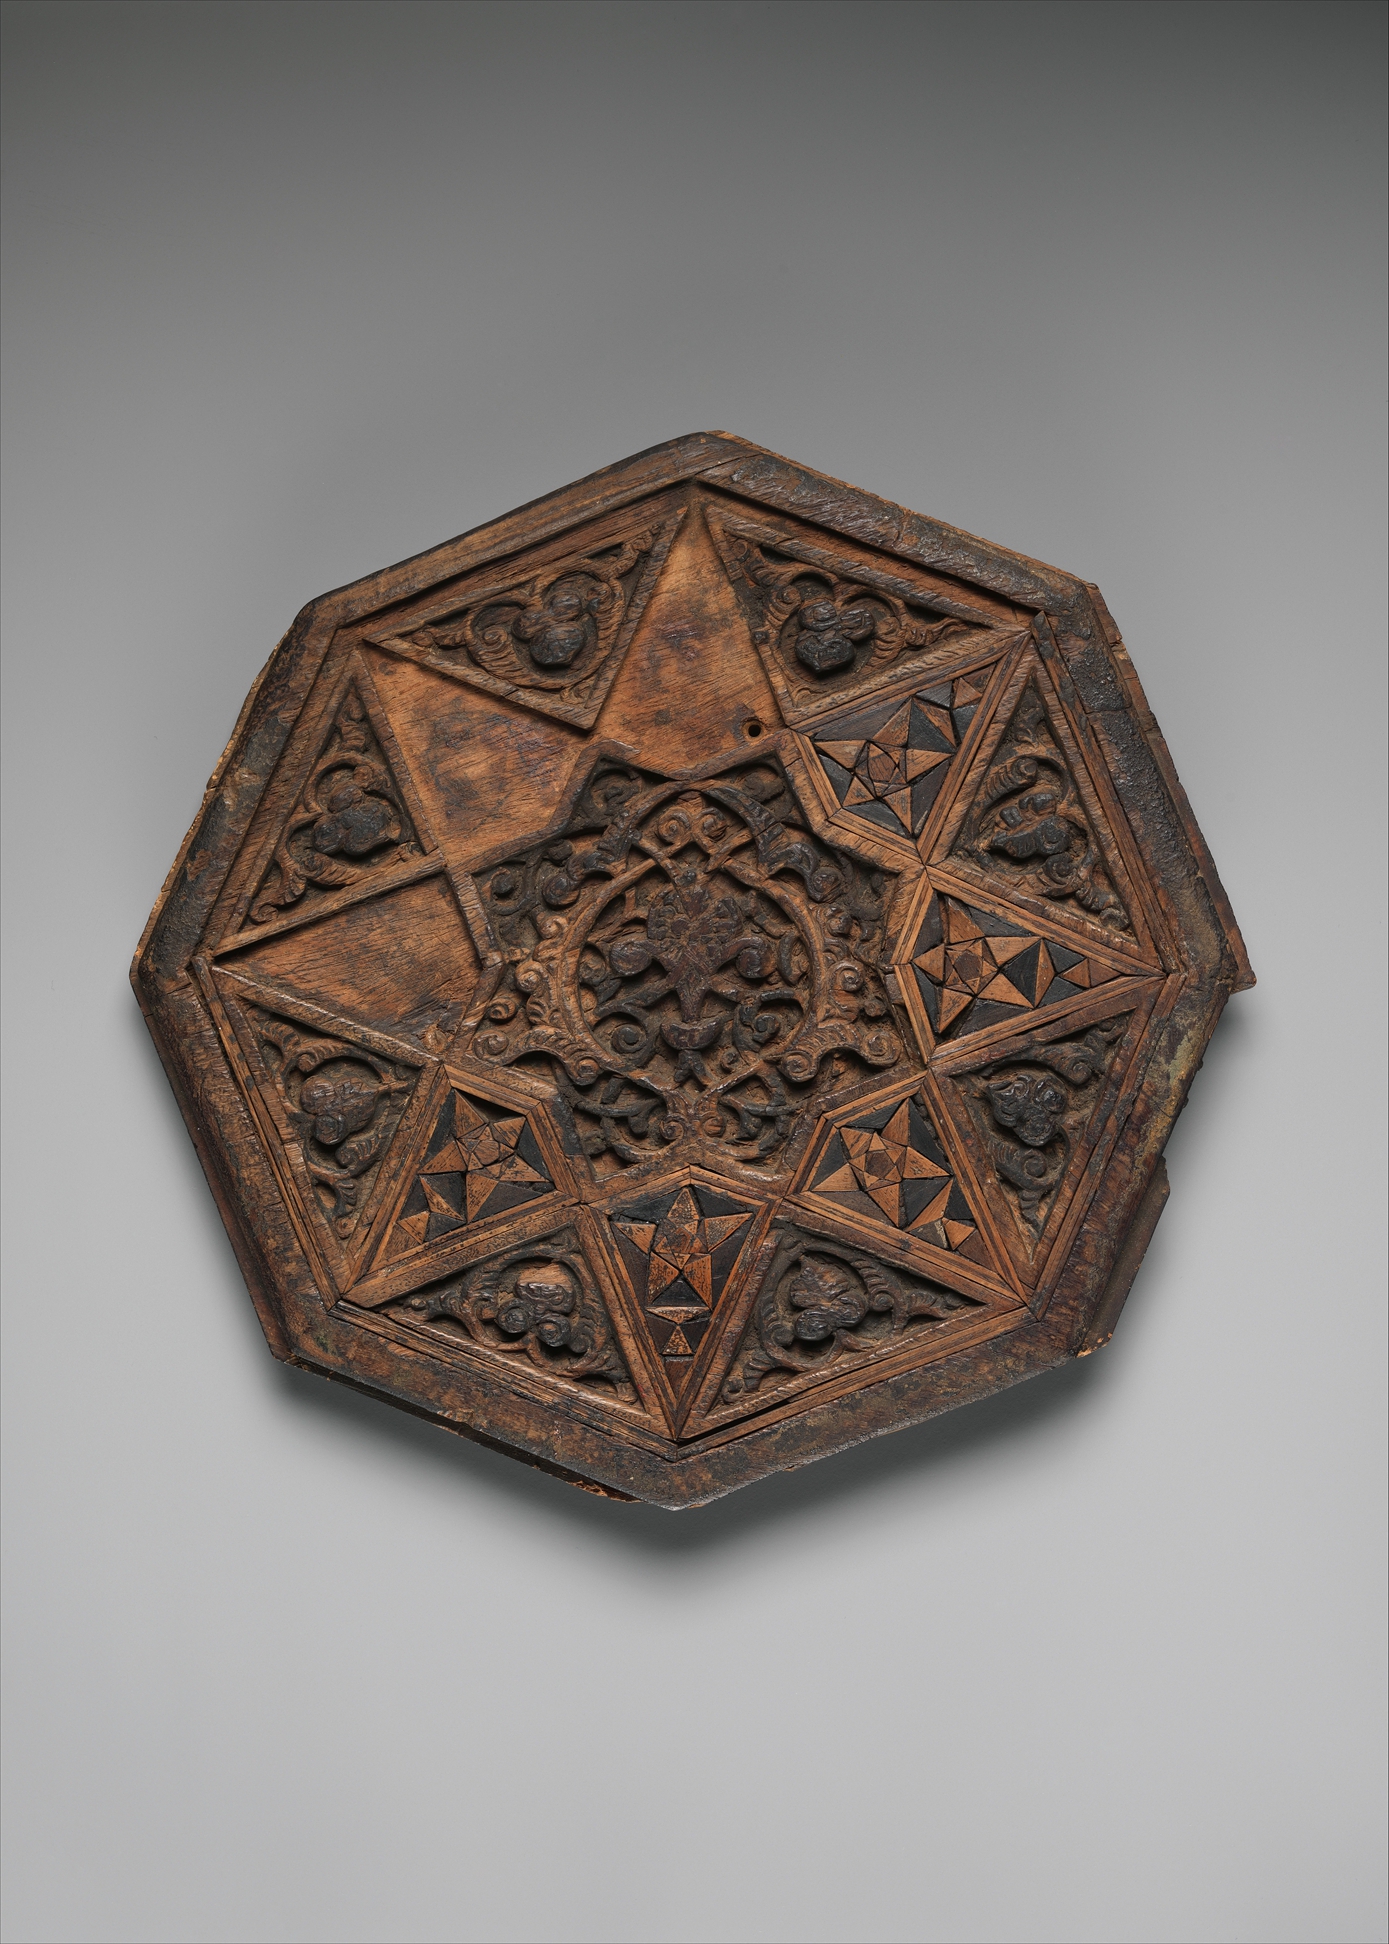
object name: panel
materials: wood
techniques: carving, inlay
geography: egypt